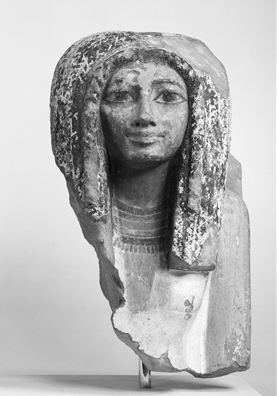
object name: statue, pair, woman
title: Upper Half of a Woman from a Pair Statue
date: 1504-1425 BCE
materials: paint, stone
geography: upper egypt, thebes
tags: women